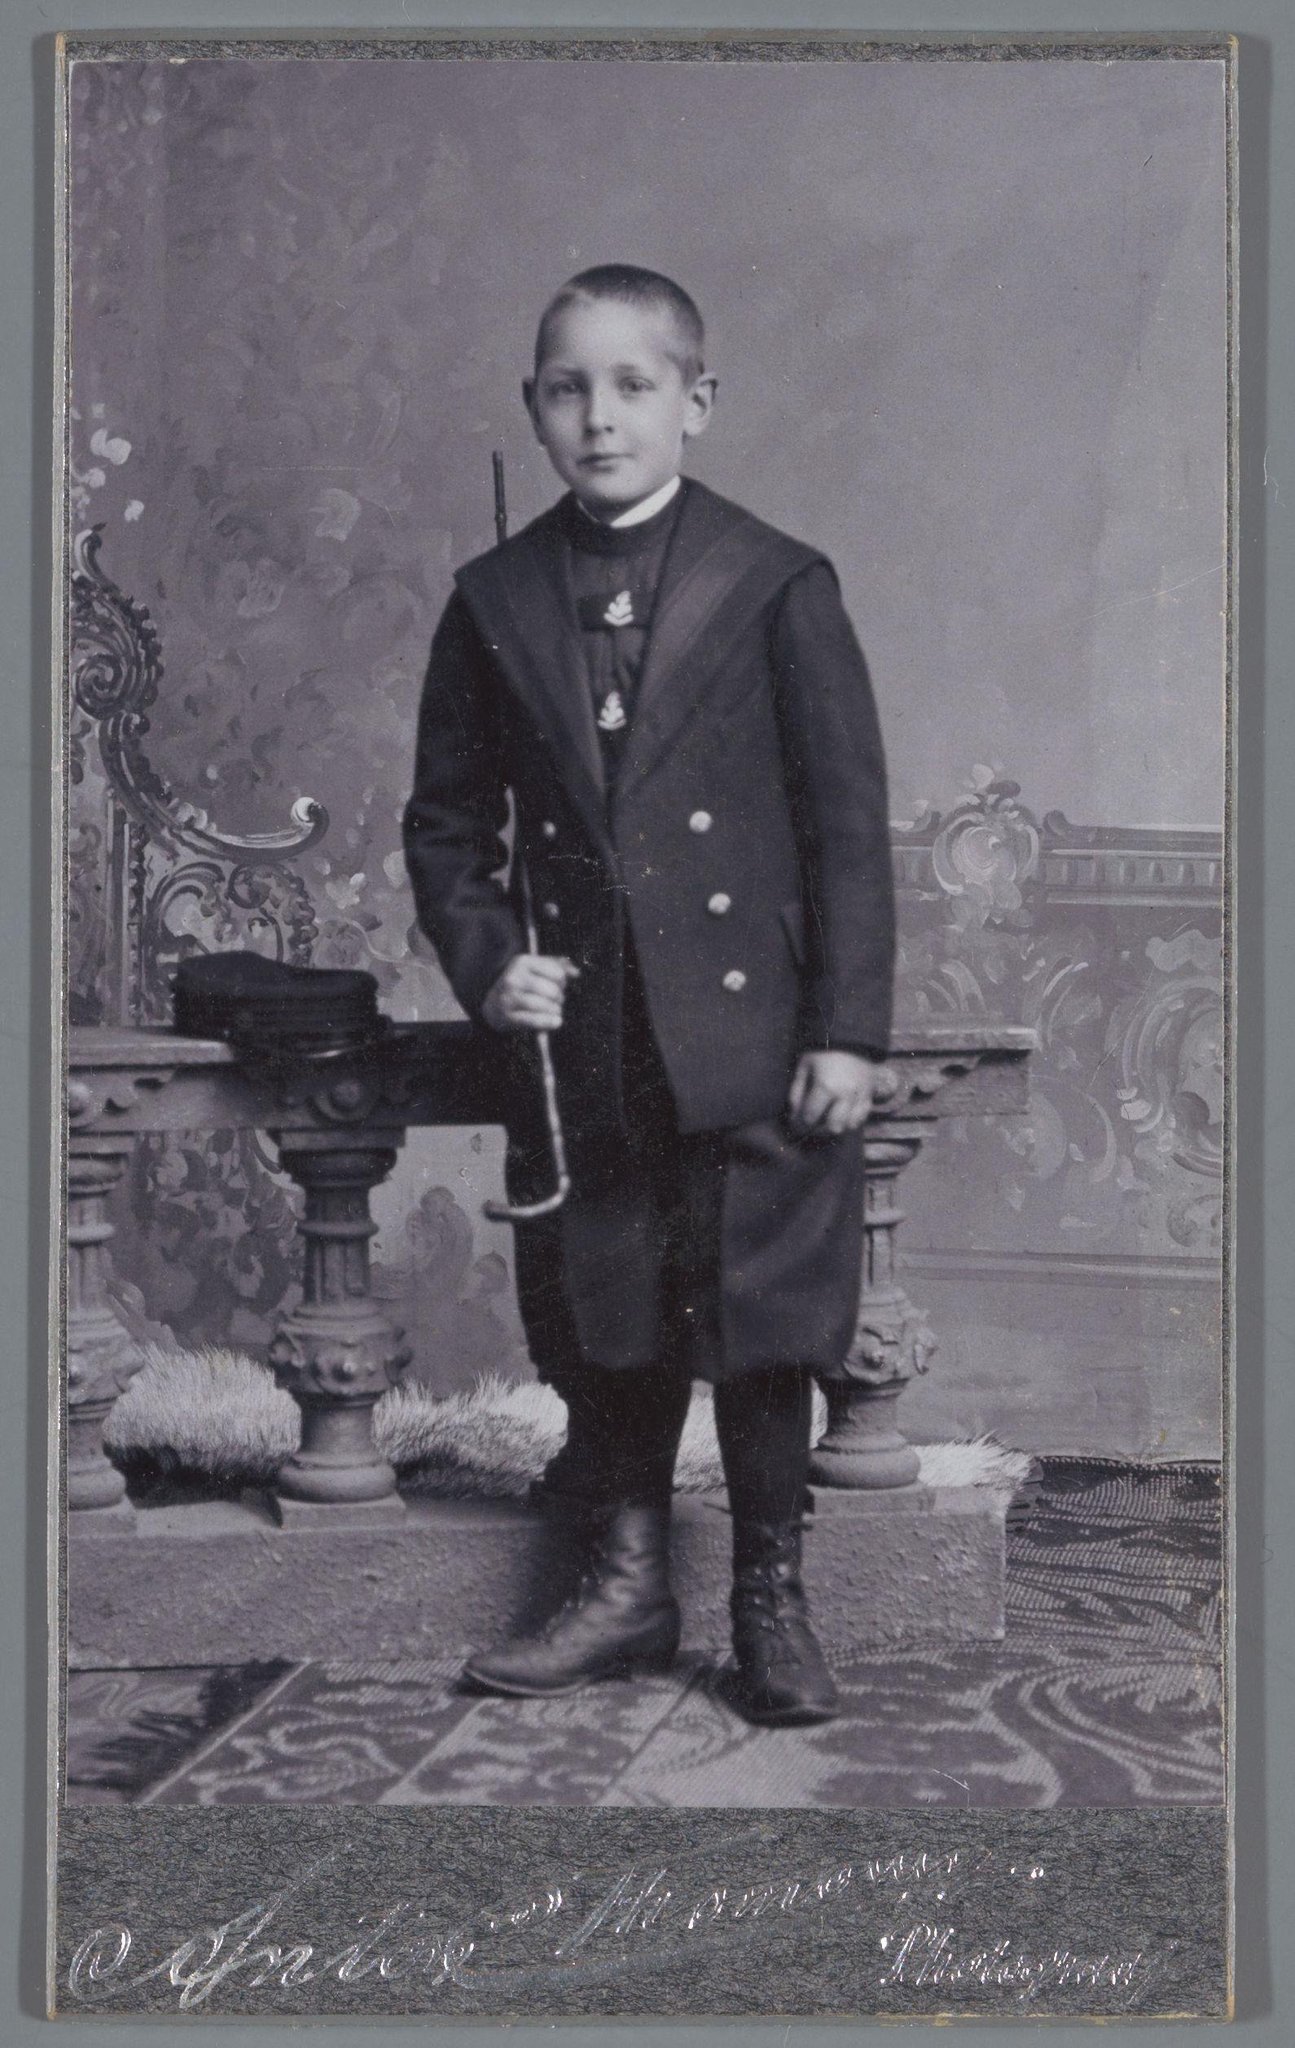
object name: carte de visite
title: Portret van een onbekende jongen met wandelstok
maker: anton cornelis thomann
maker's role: fotograaf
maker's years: 1873-1946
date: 1902-1909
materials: paper, cardboard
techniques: collodion silver print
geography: utrecht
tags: boy (child between toddler and youth), anonymous historical person portrayed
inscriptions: address: ‘Utrecht/ Witte vrouwe singel 91 5e huis van af de gasfabr.’, inscription: ‘intercommunaal telefoon/ nummer 893/ Electro-Fotografie/ Eigen - vinding/ Poseertijd 1/50 tot 1/100 secunde, stil zijn derhalve geheel onnoodig./ Besust artistieke belichting, de opnamen kunnen geschieden/ zoowel bij het sterkste daglicht als bij avond Des avonds/ alleen op voorafgaand verzoek./ ONDERSCHEIDINGEN/ BERLIJN 1900/ GRONINGEN 1901/ DUSSELDORP 1902/ BRUSSEL 1902/ Prager & Lojda, Berlin./ 26504’